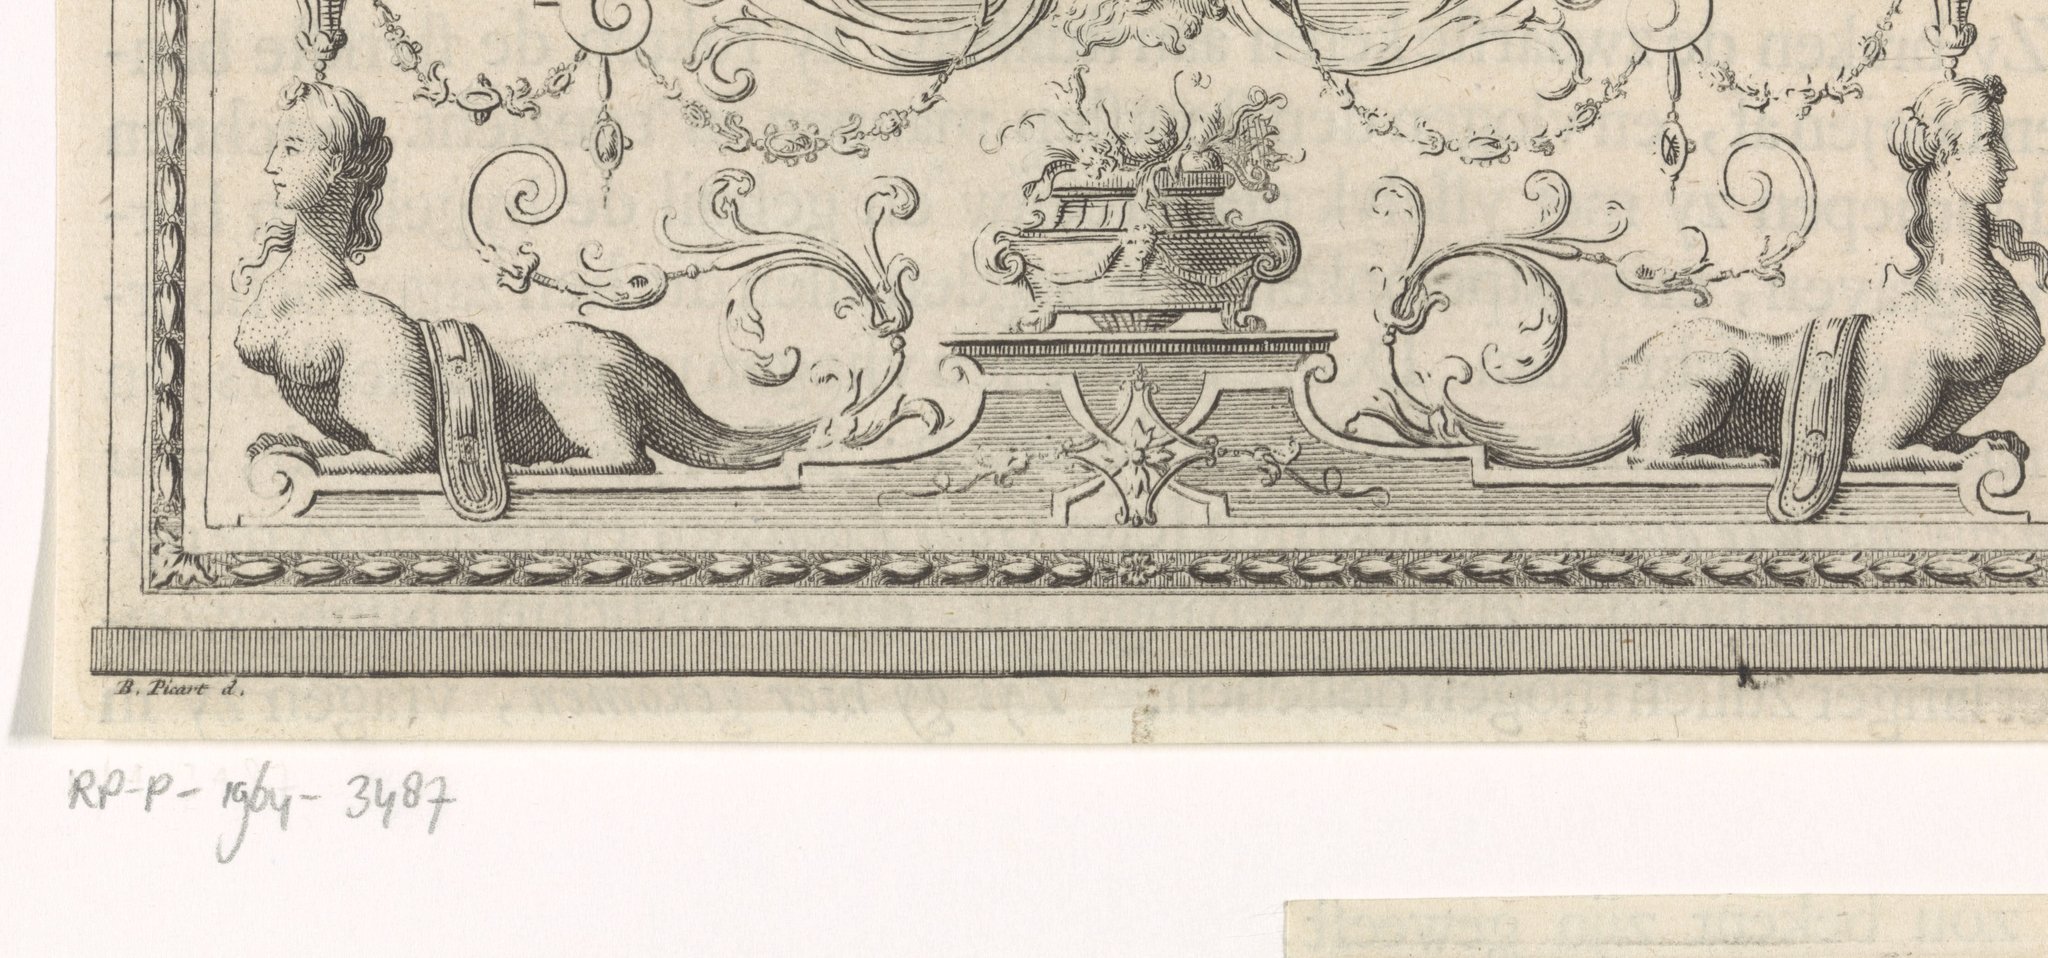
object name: ornament print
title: Ornament met een vaas in het midden geflankeerd door sfinxen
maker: bernard picart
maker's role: draughtsman, print maker, publisher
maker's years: 1673-1733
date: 1683-1733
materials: paper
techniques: engraving, etching, letterpress printing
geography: amsterdam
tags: sphinx (lion/woman); 'sfinge' (ripa), mask, mascaron ~ ornament, ornament ~ festoon, garland, foliage, tendrils, branches ~ ornament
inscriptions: collector's mark: Lugt 2228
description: Prent oorspronkelijk bedoeld voor: Figures de la Bible. Amsterdam, Bernard Picart, 1720. Prent ook gebruikt in: Taferelen der voornaamste geschiedenissen van het Oude en Nieuwe Testament (...) door de vermaarde kunstenaars Hoet, Houbraken, en Picart getekent (...) en met beschrijvingen uitgebreid. Den Haag: Pieter de Hondt, 1728. Prent kan mogelijk ook zijn gebruikt in andere bijbels.